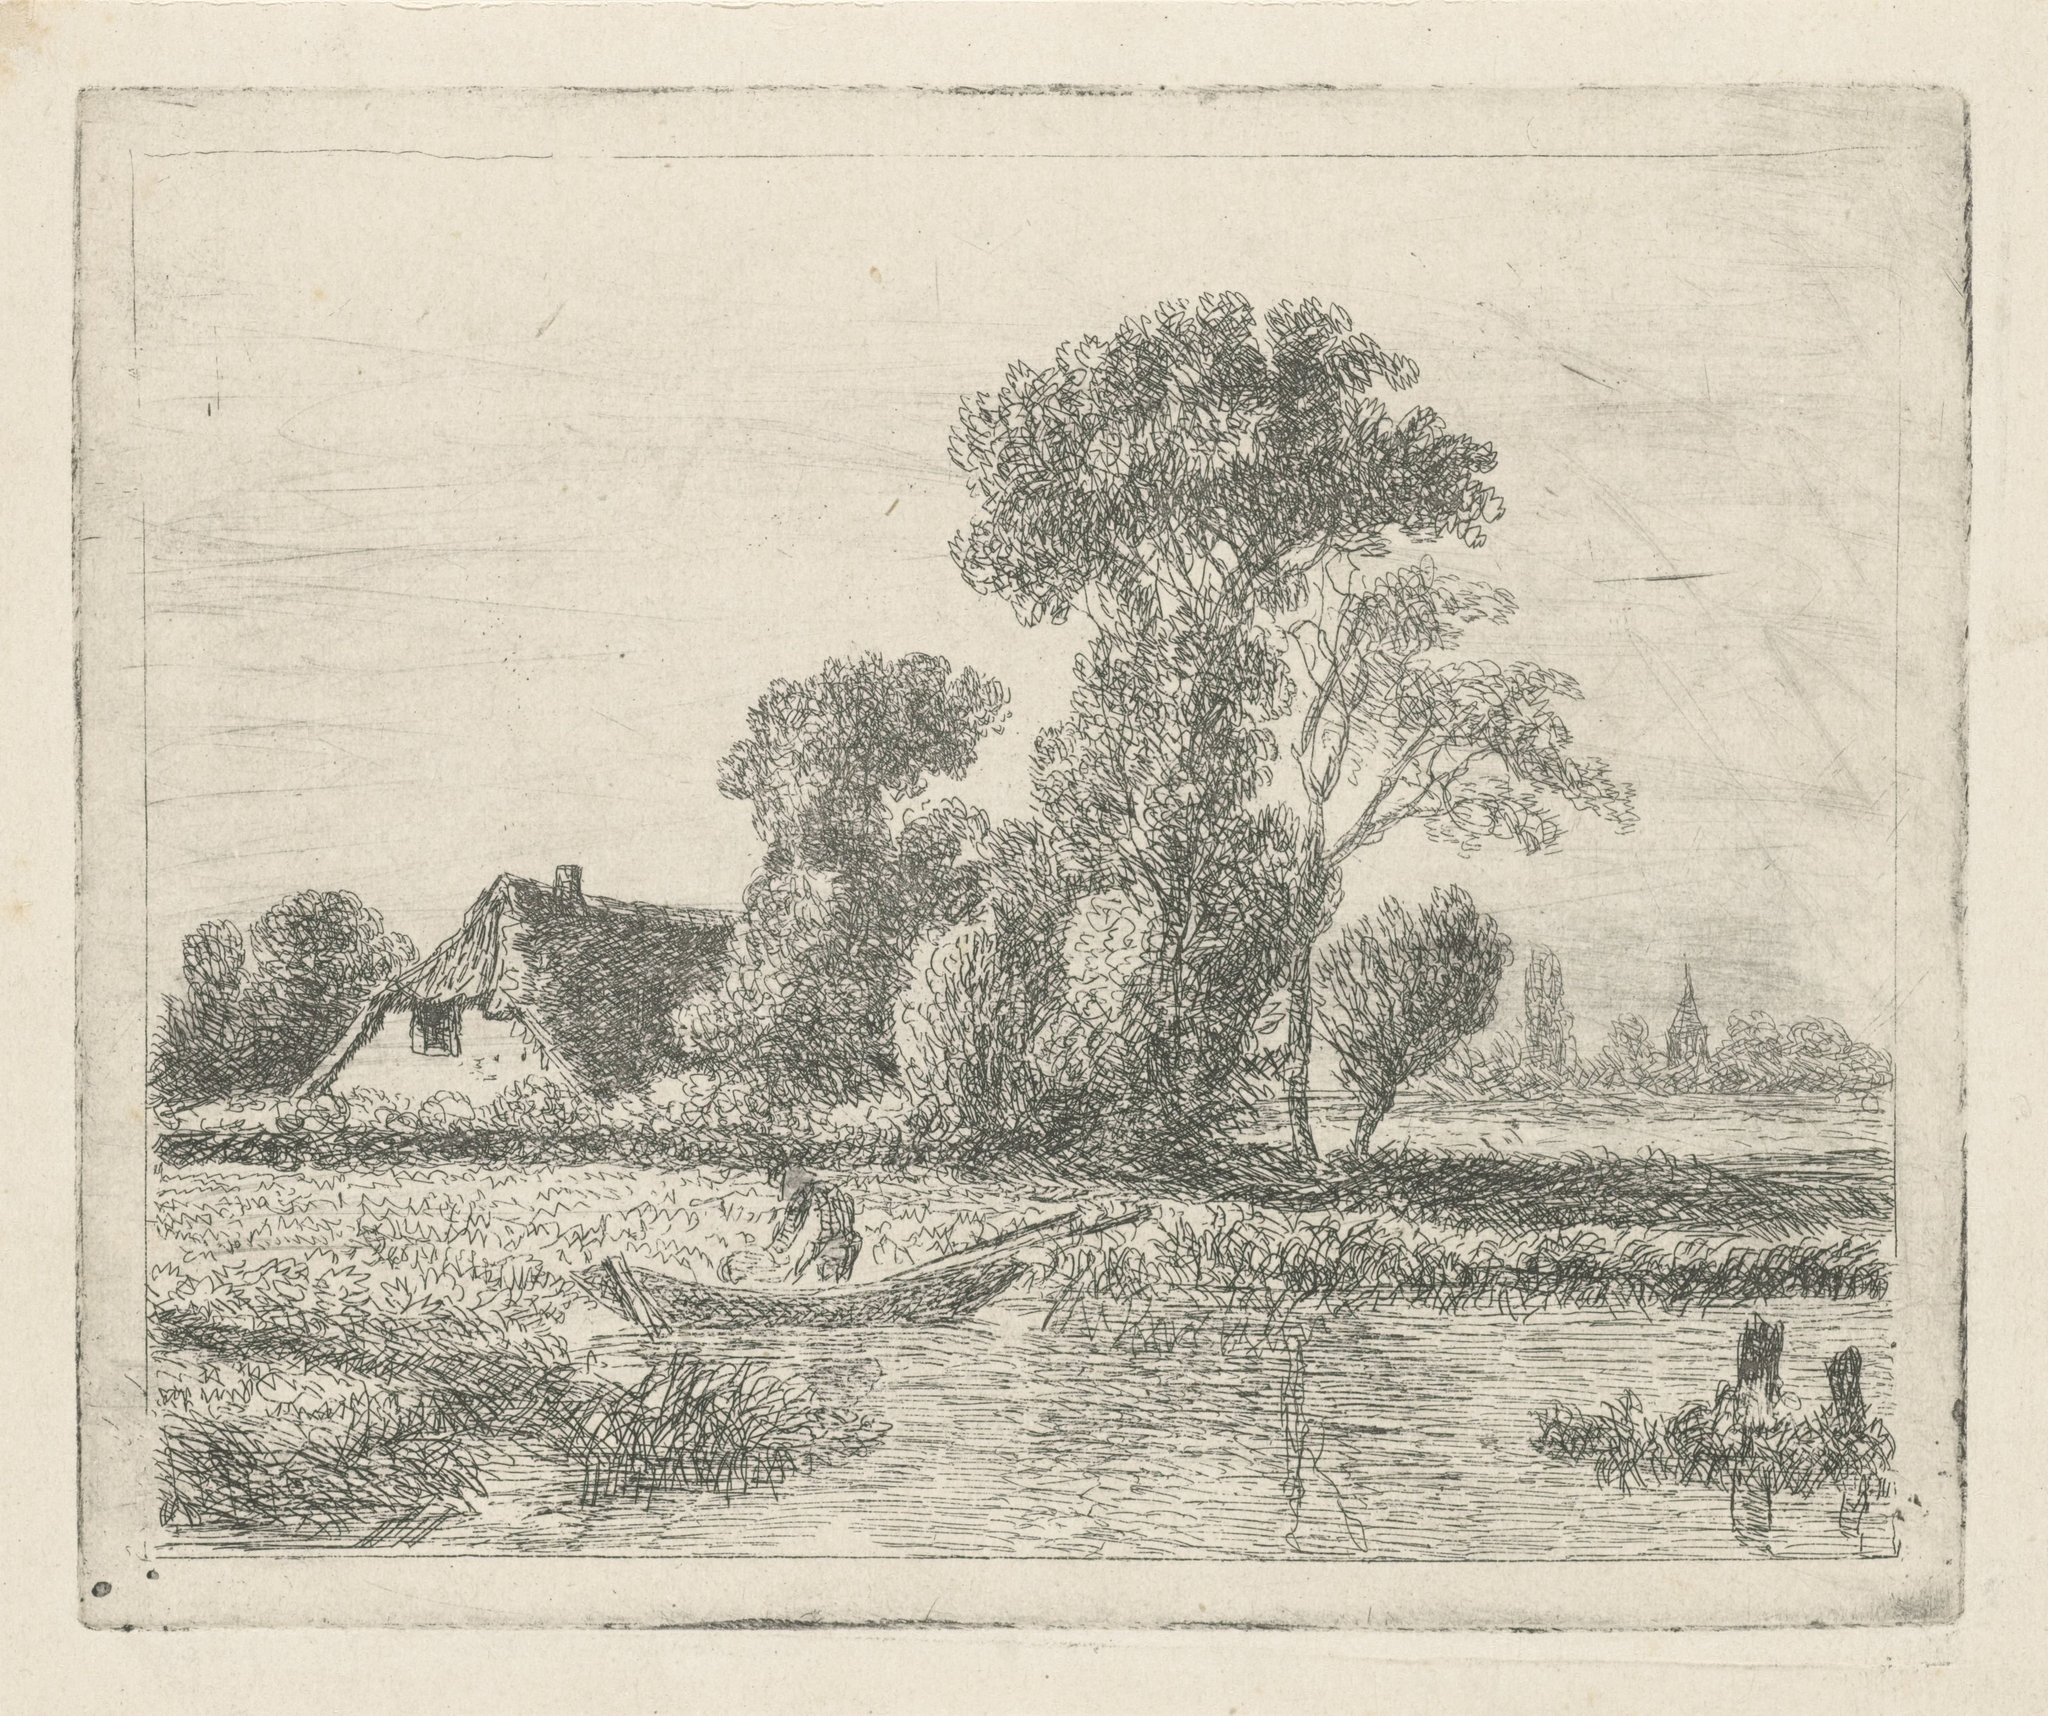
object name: print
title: Visser in een roeiboot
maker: hermanus jan hendrik van rijkelijkhuysen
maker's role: painter, print maker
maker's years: 1813-1883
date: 1823-1883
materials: paper, pencil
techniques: etching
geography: utrecht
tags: river, church (exterior), rowing-boat, canoe, etc., farm or solitary house in landscape, fisherman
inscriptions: collector's mark: Lugt 2228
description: Gezicht op een rivierlandschap met op de voorgrond een boot met daarin een visser. Aan de waterkant een boerenhoeve en op de achtergrond de contouren van een kerk.